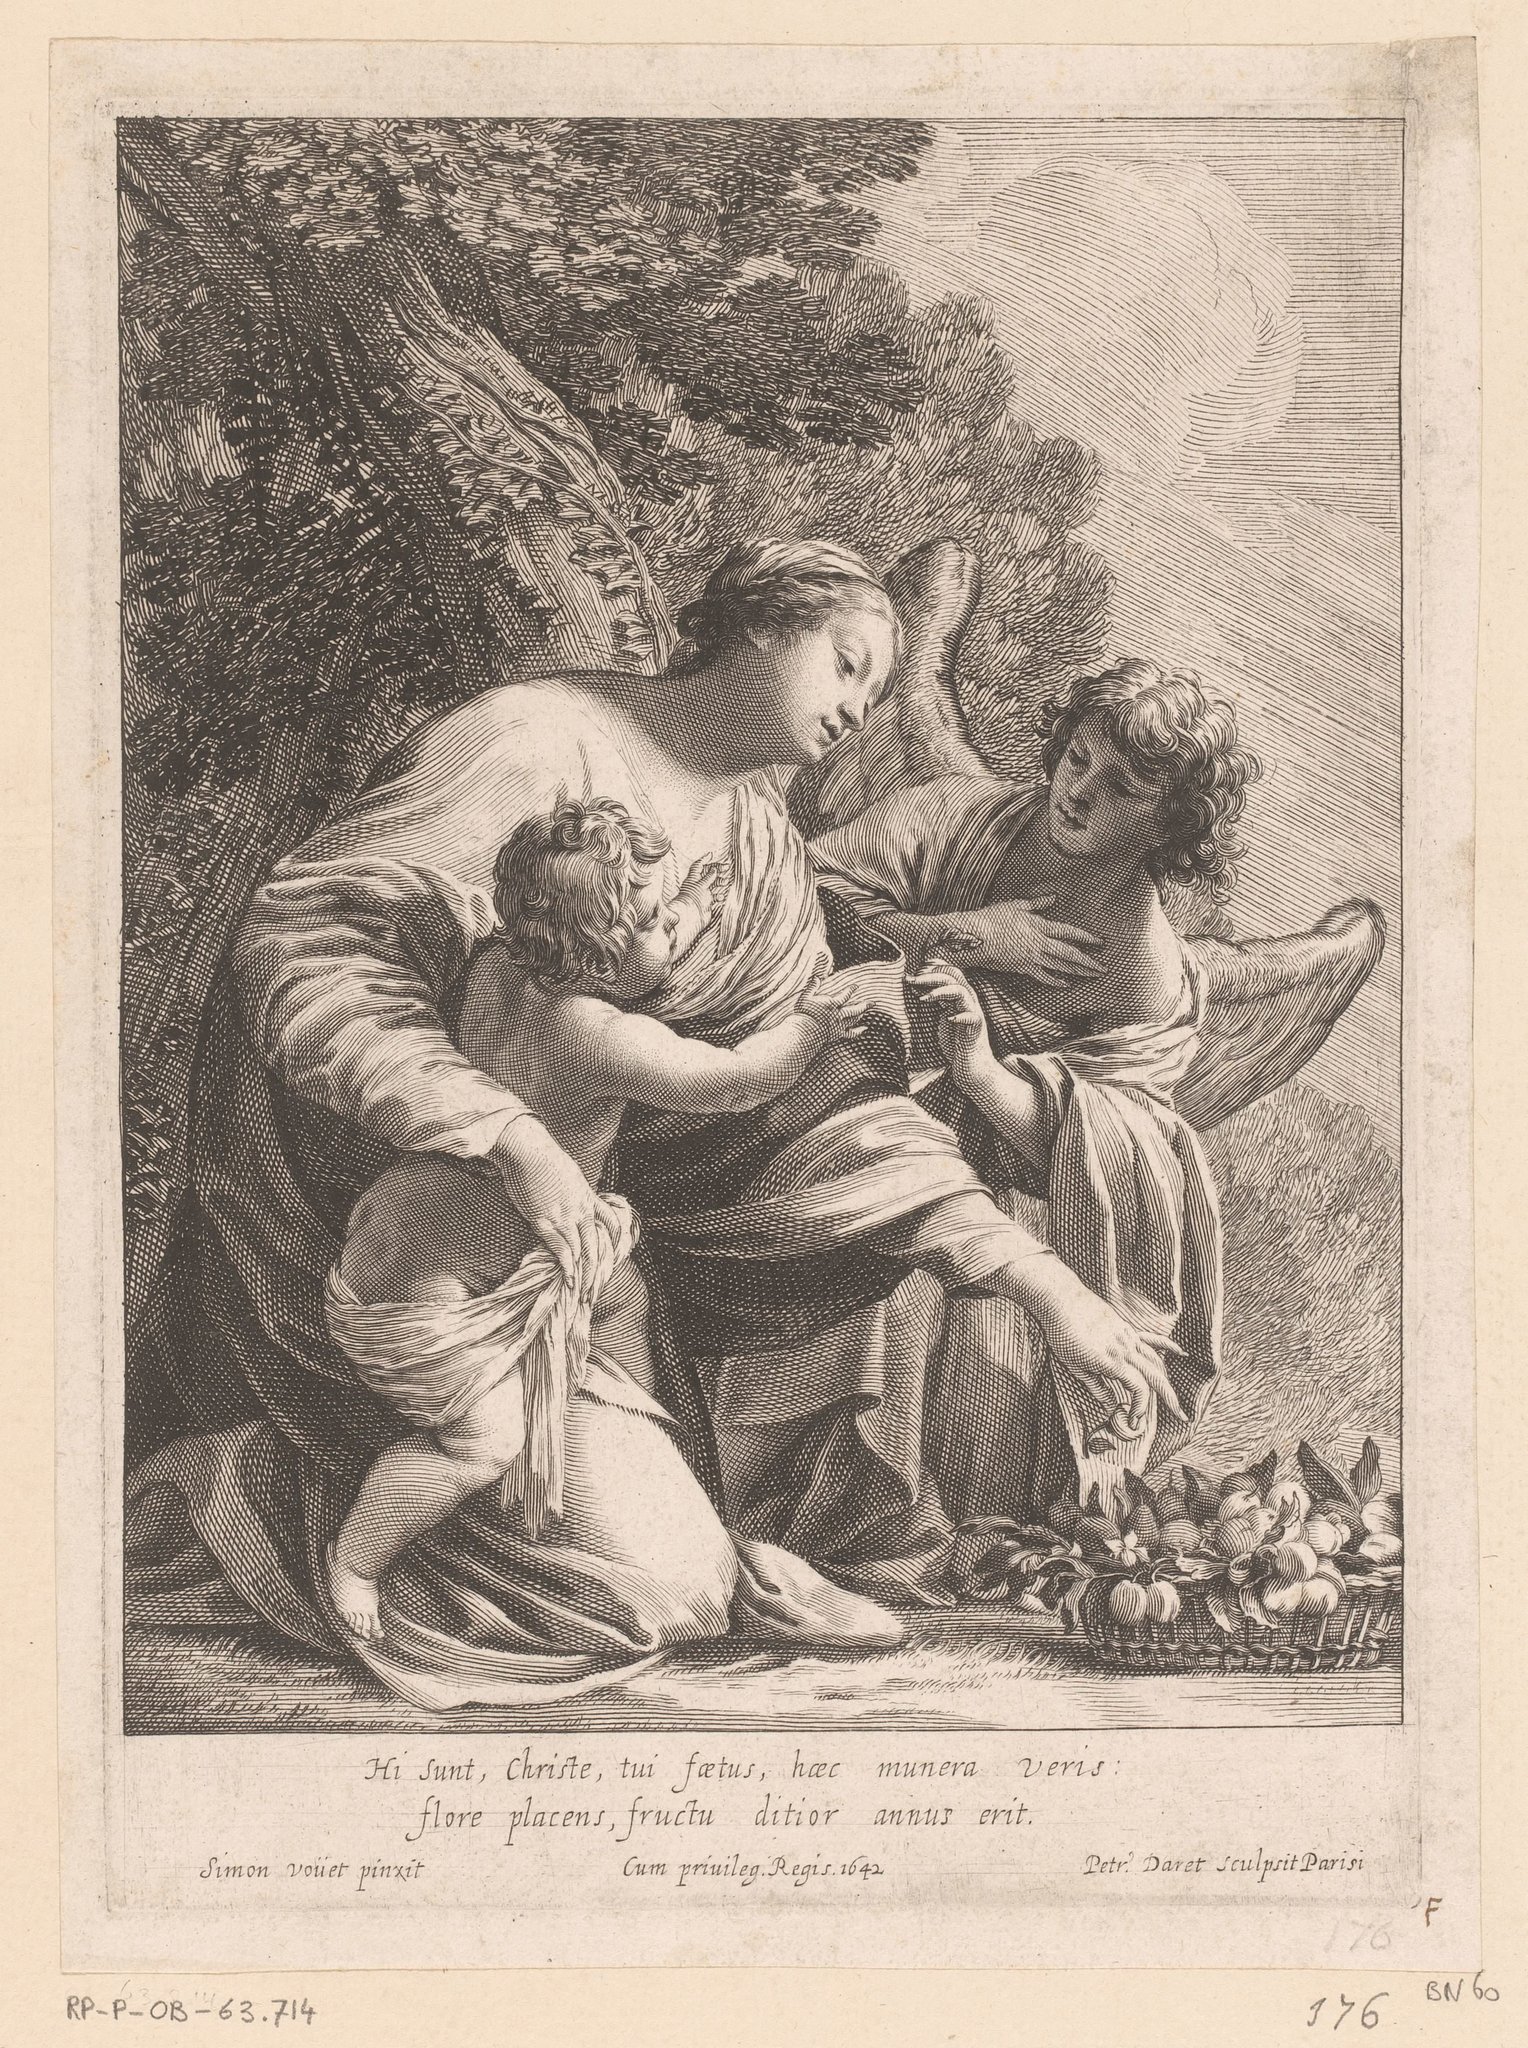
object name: print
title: Maria met Kind en een engel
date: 1642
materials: paper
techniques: engraving, etching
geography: france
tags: madonna (i.e. mary with the christ-child) accompanied or surrounded by others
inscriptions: collector's mark: Lugt 240